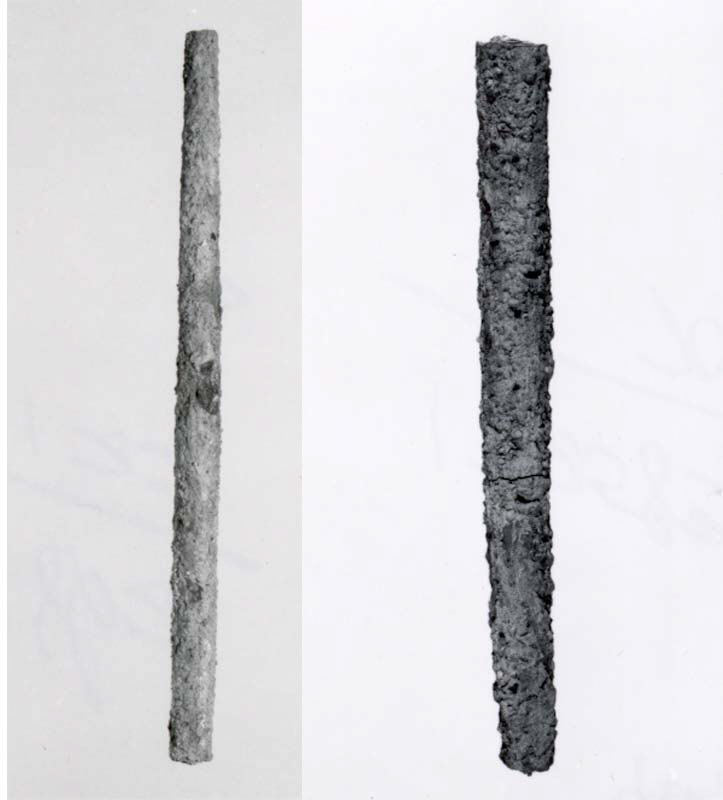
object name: tube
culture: iranian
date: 900-801 BCE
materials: bronze, copper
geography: iran